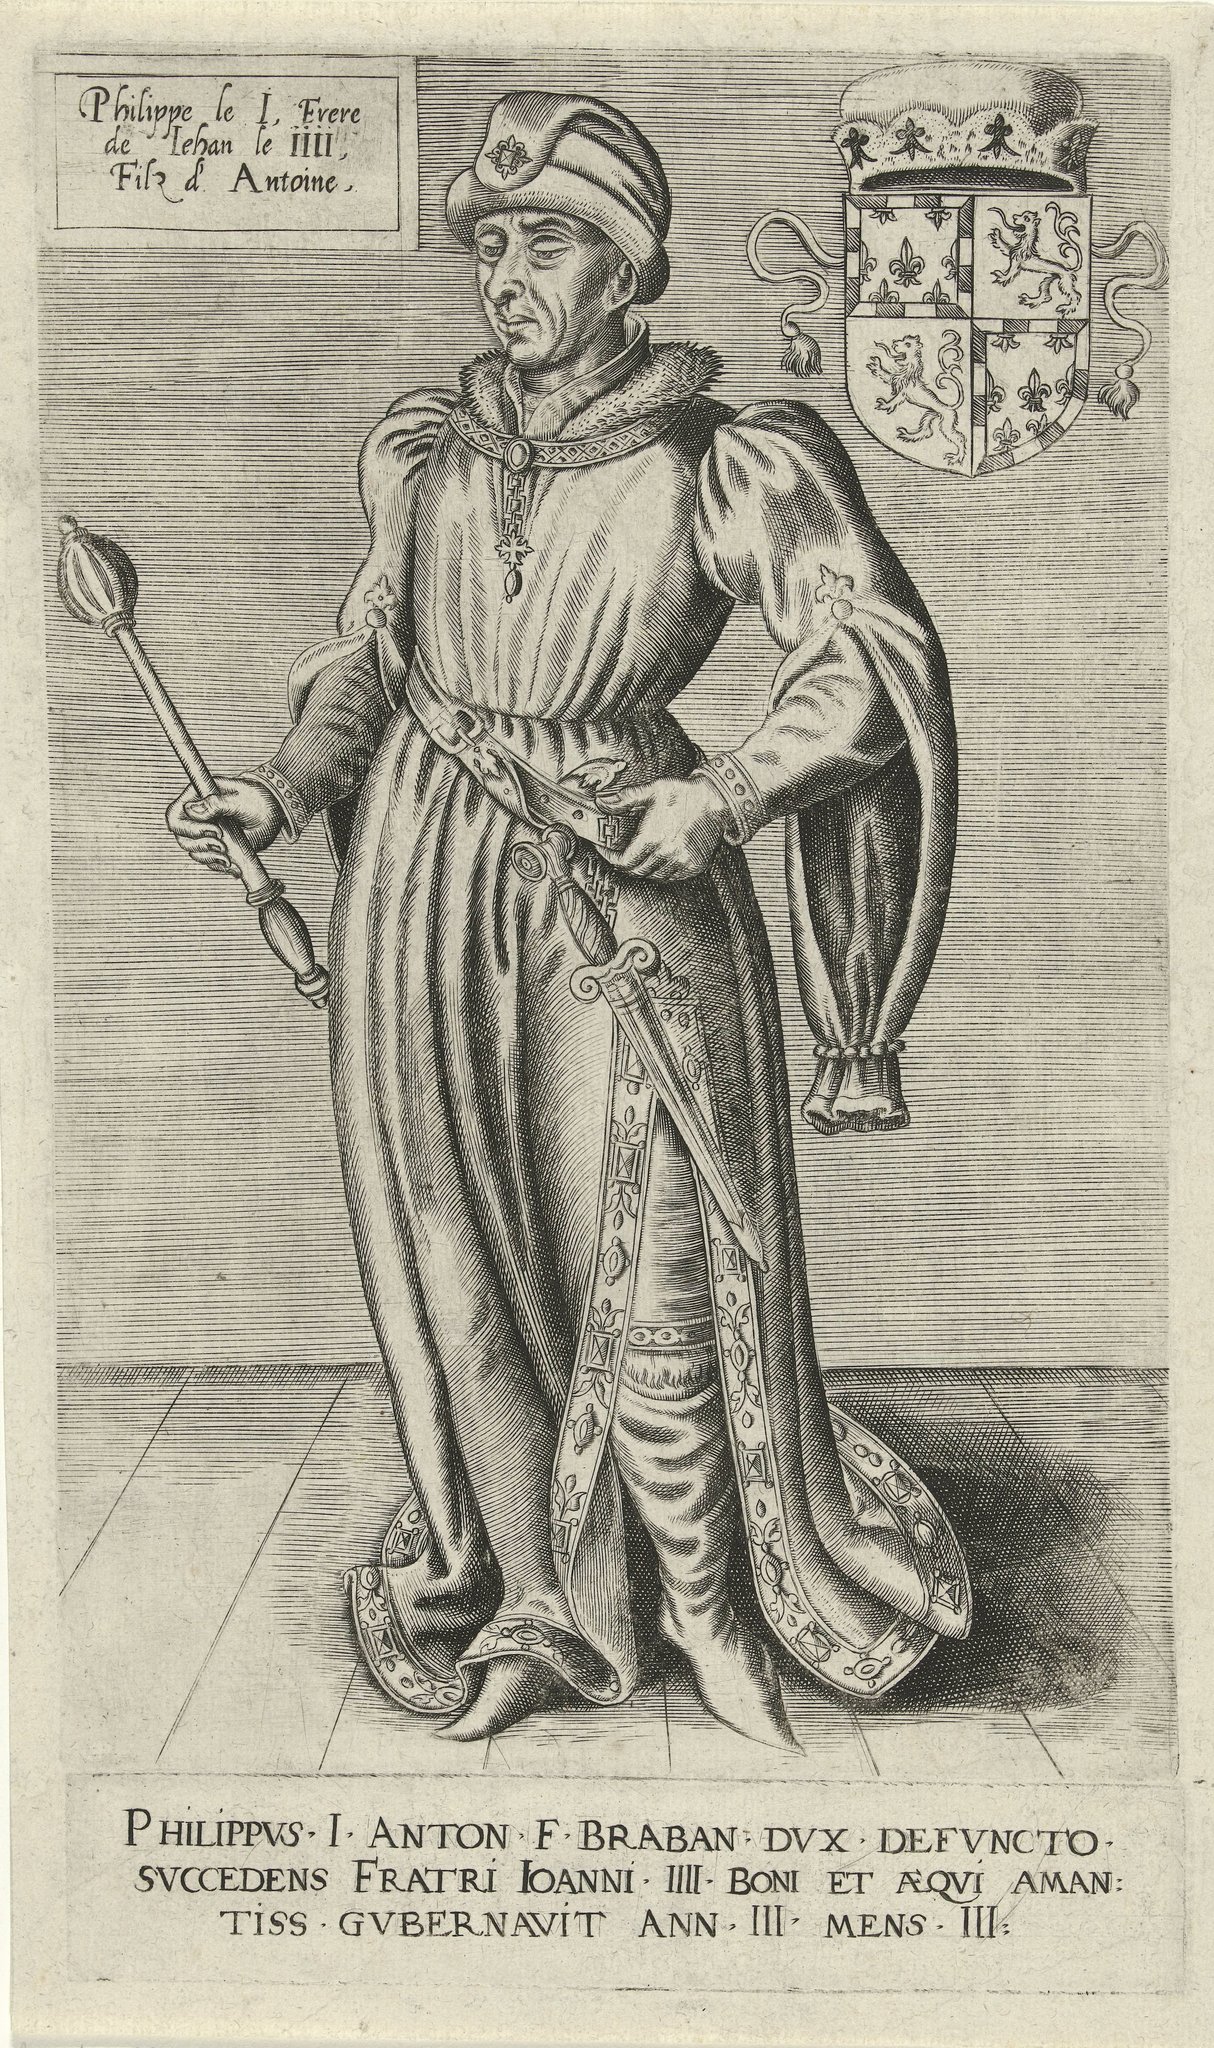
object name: print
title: Portret van Filips van Saint-Pol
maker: frans huys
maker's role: print maker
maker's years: 1522-1562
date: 1546-1562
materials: paper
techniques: engraving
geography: antwerp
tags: hertog, filips van saint-pol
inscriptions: collector's mark: Lugt 2228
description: Portret van Filips van Saint-Pol, hertog van Brabant, ten voeten uit, in zijn rechterhand een scepter. Rechtsboven zijn wapen. Het drieregelige onderschrift in het Latijn is op een afzonderlijke plaat gegraveerd.